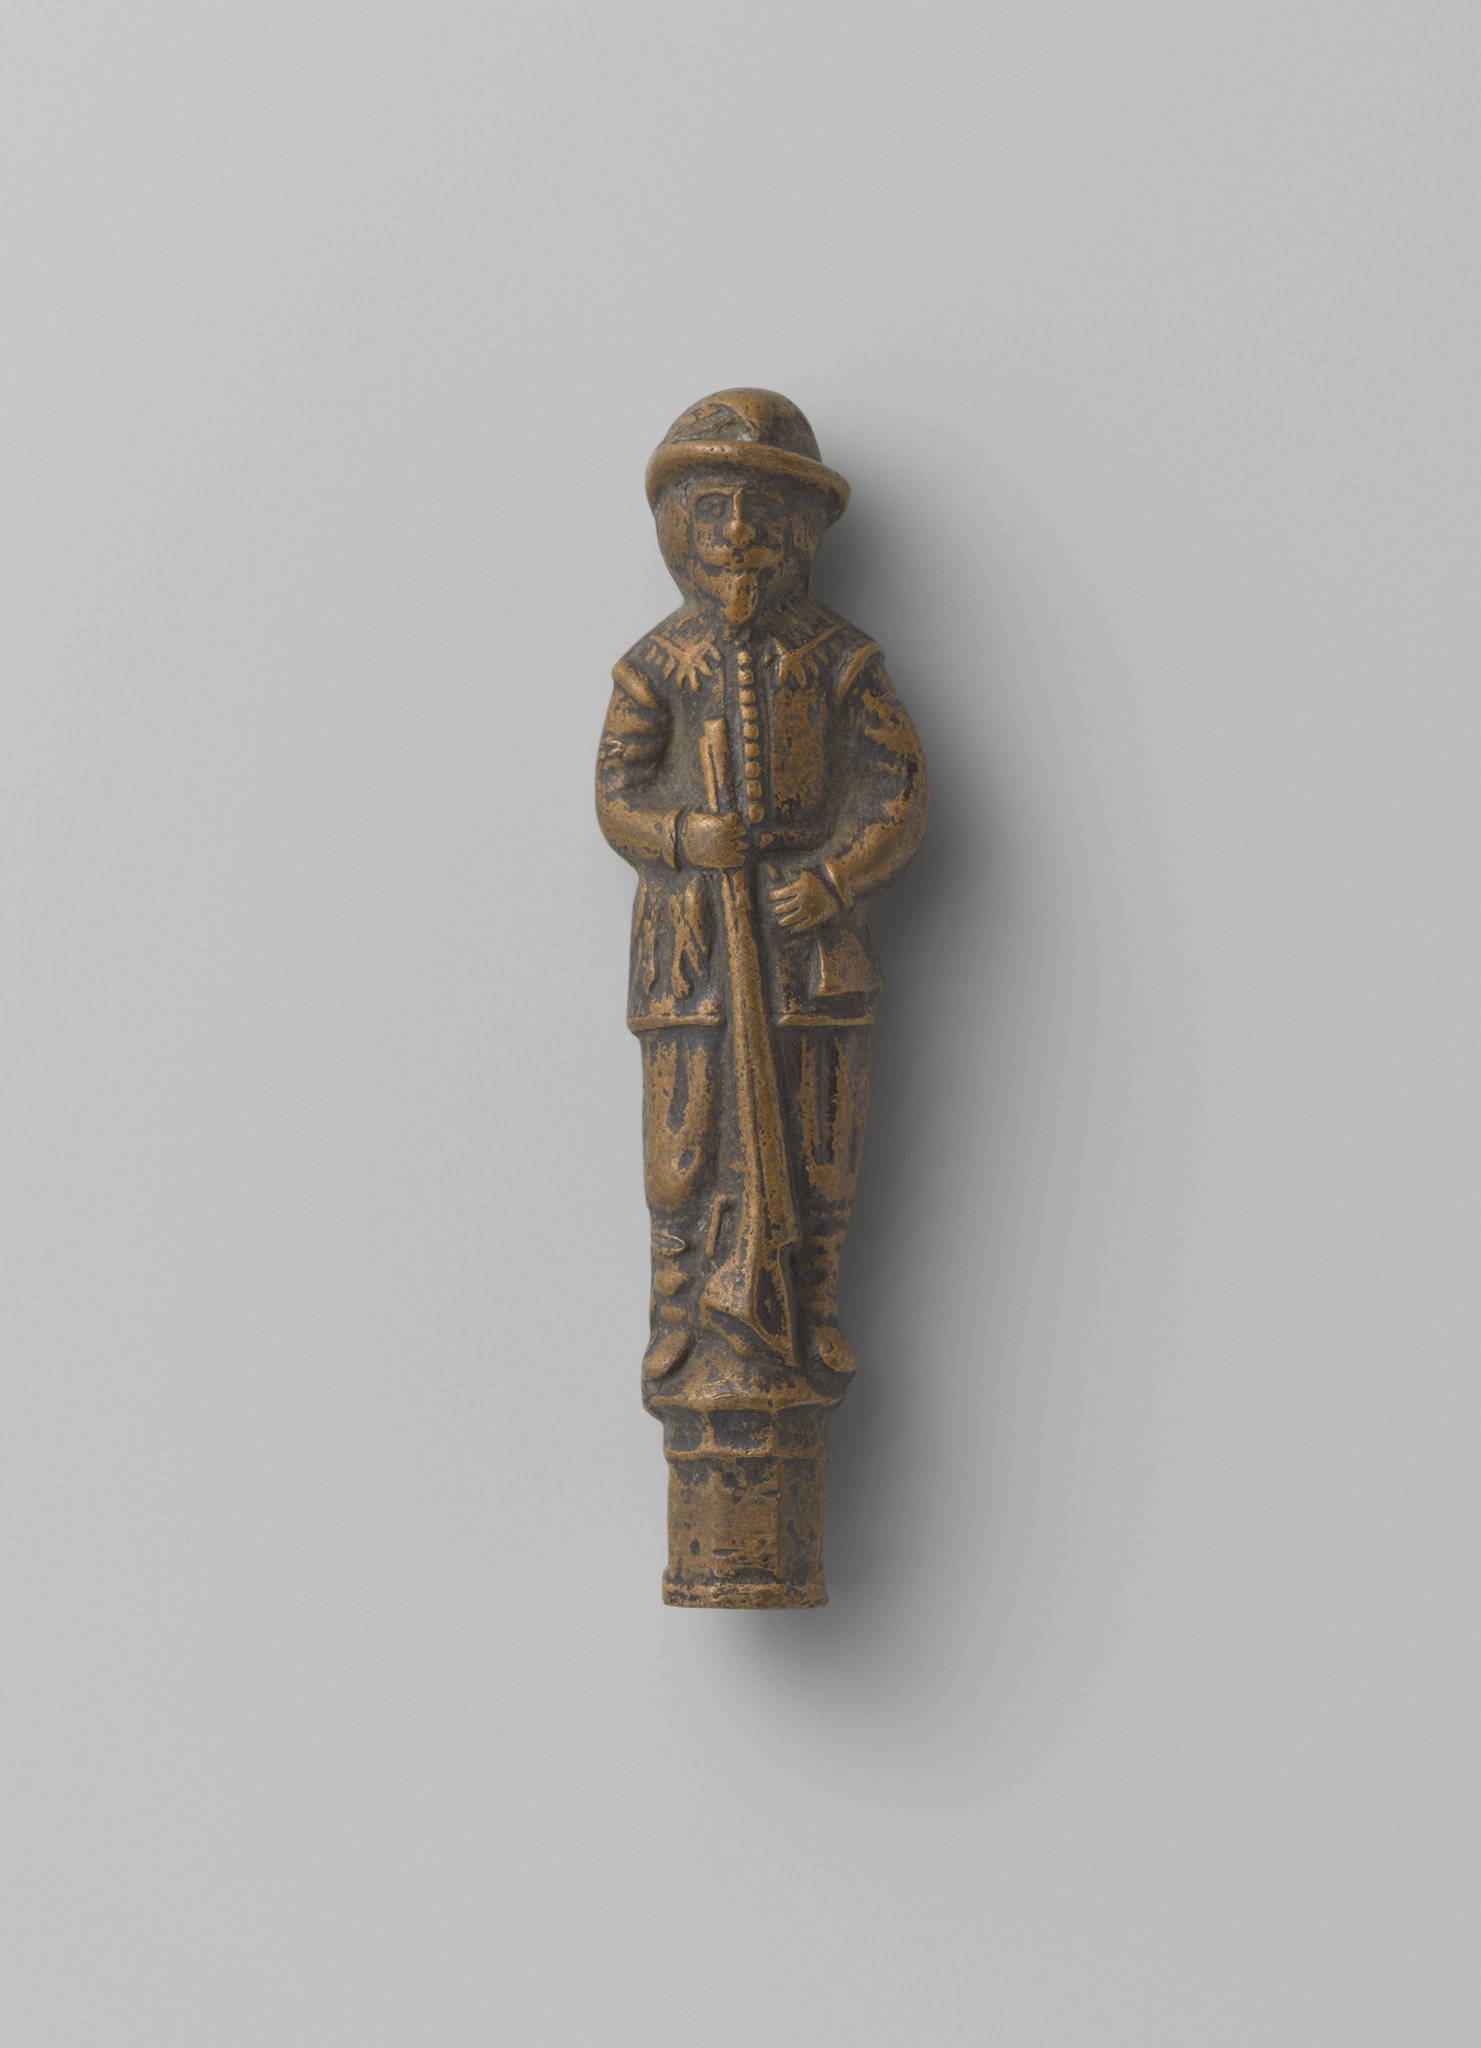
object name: knife handle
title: Mes met heft in de vorm van een man met musket en jachthond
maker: Anonymous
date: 1600-1650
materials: brass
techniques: casting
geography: netherlands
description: Een dergelijk heft is gevonden in het wrak van het schip 'De Lastdrager', dat in 1653 bij Shetland is vergaan. Onno ter Kuile, 1986.